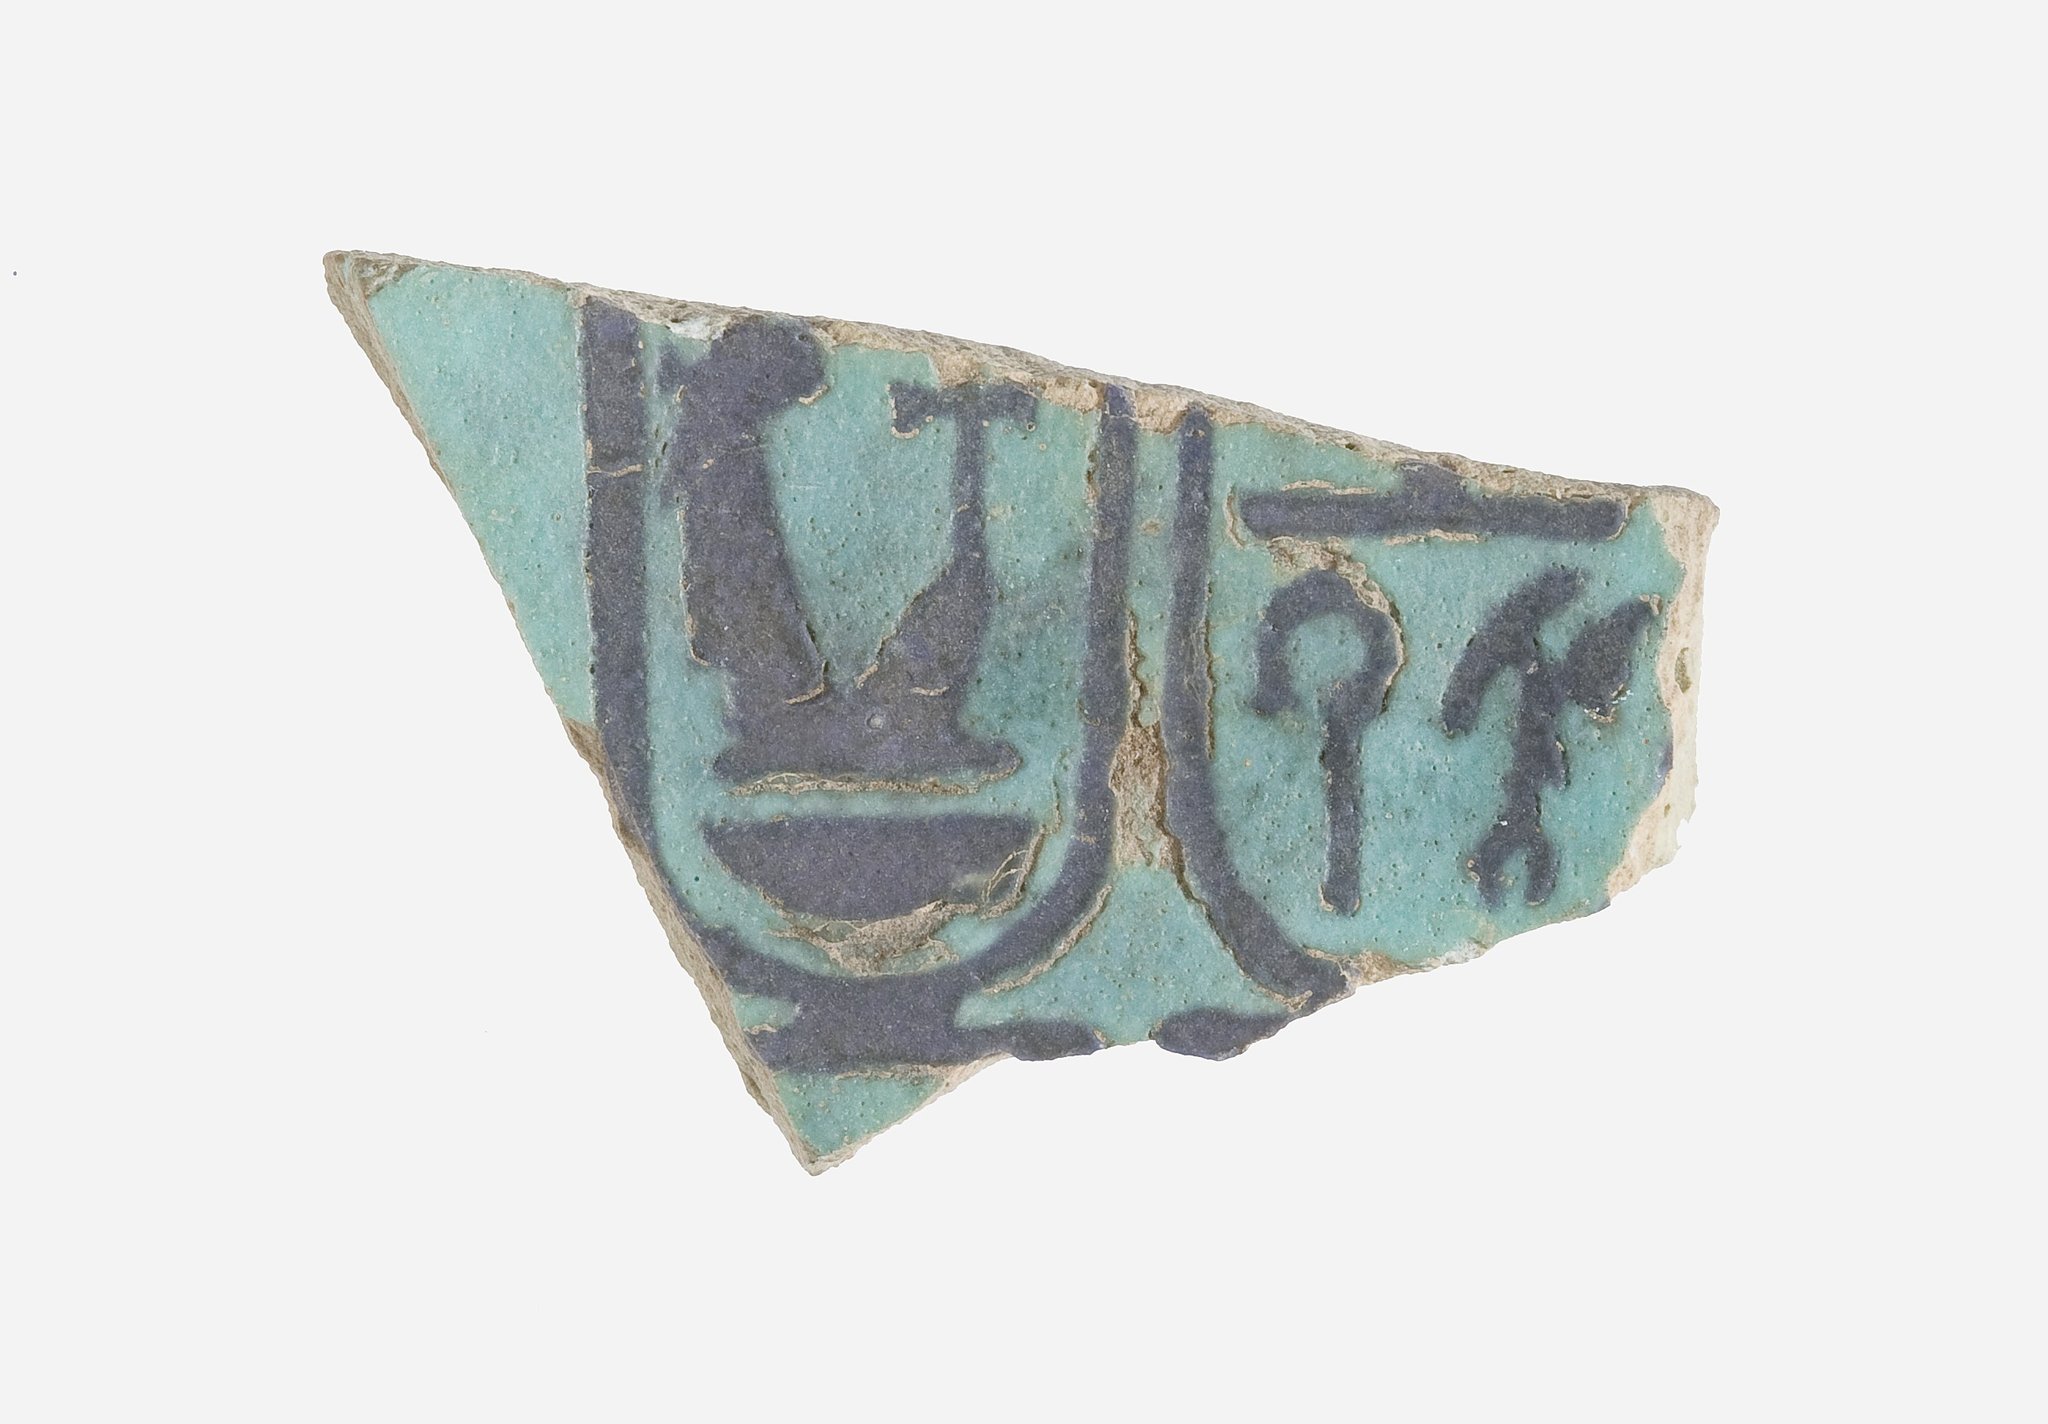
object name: dish fragment, nebmaatre, amenhotep iii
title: Fragment of a Toilet Dish with Cartouches of Amenhotep III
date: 1390-1352 BCE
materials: faience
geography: egypt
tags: cartouches